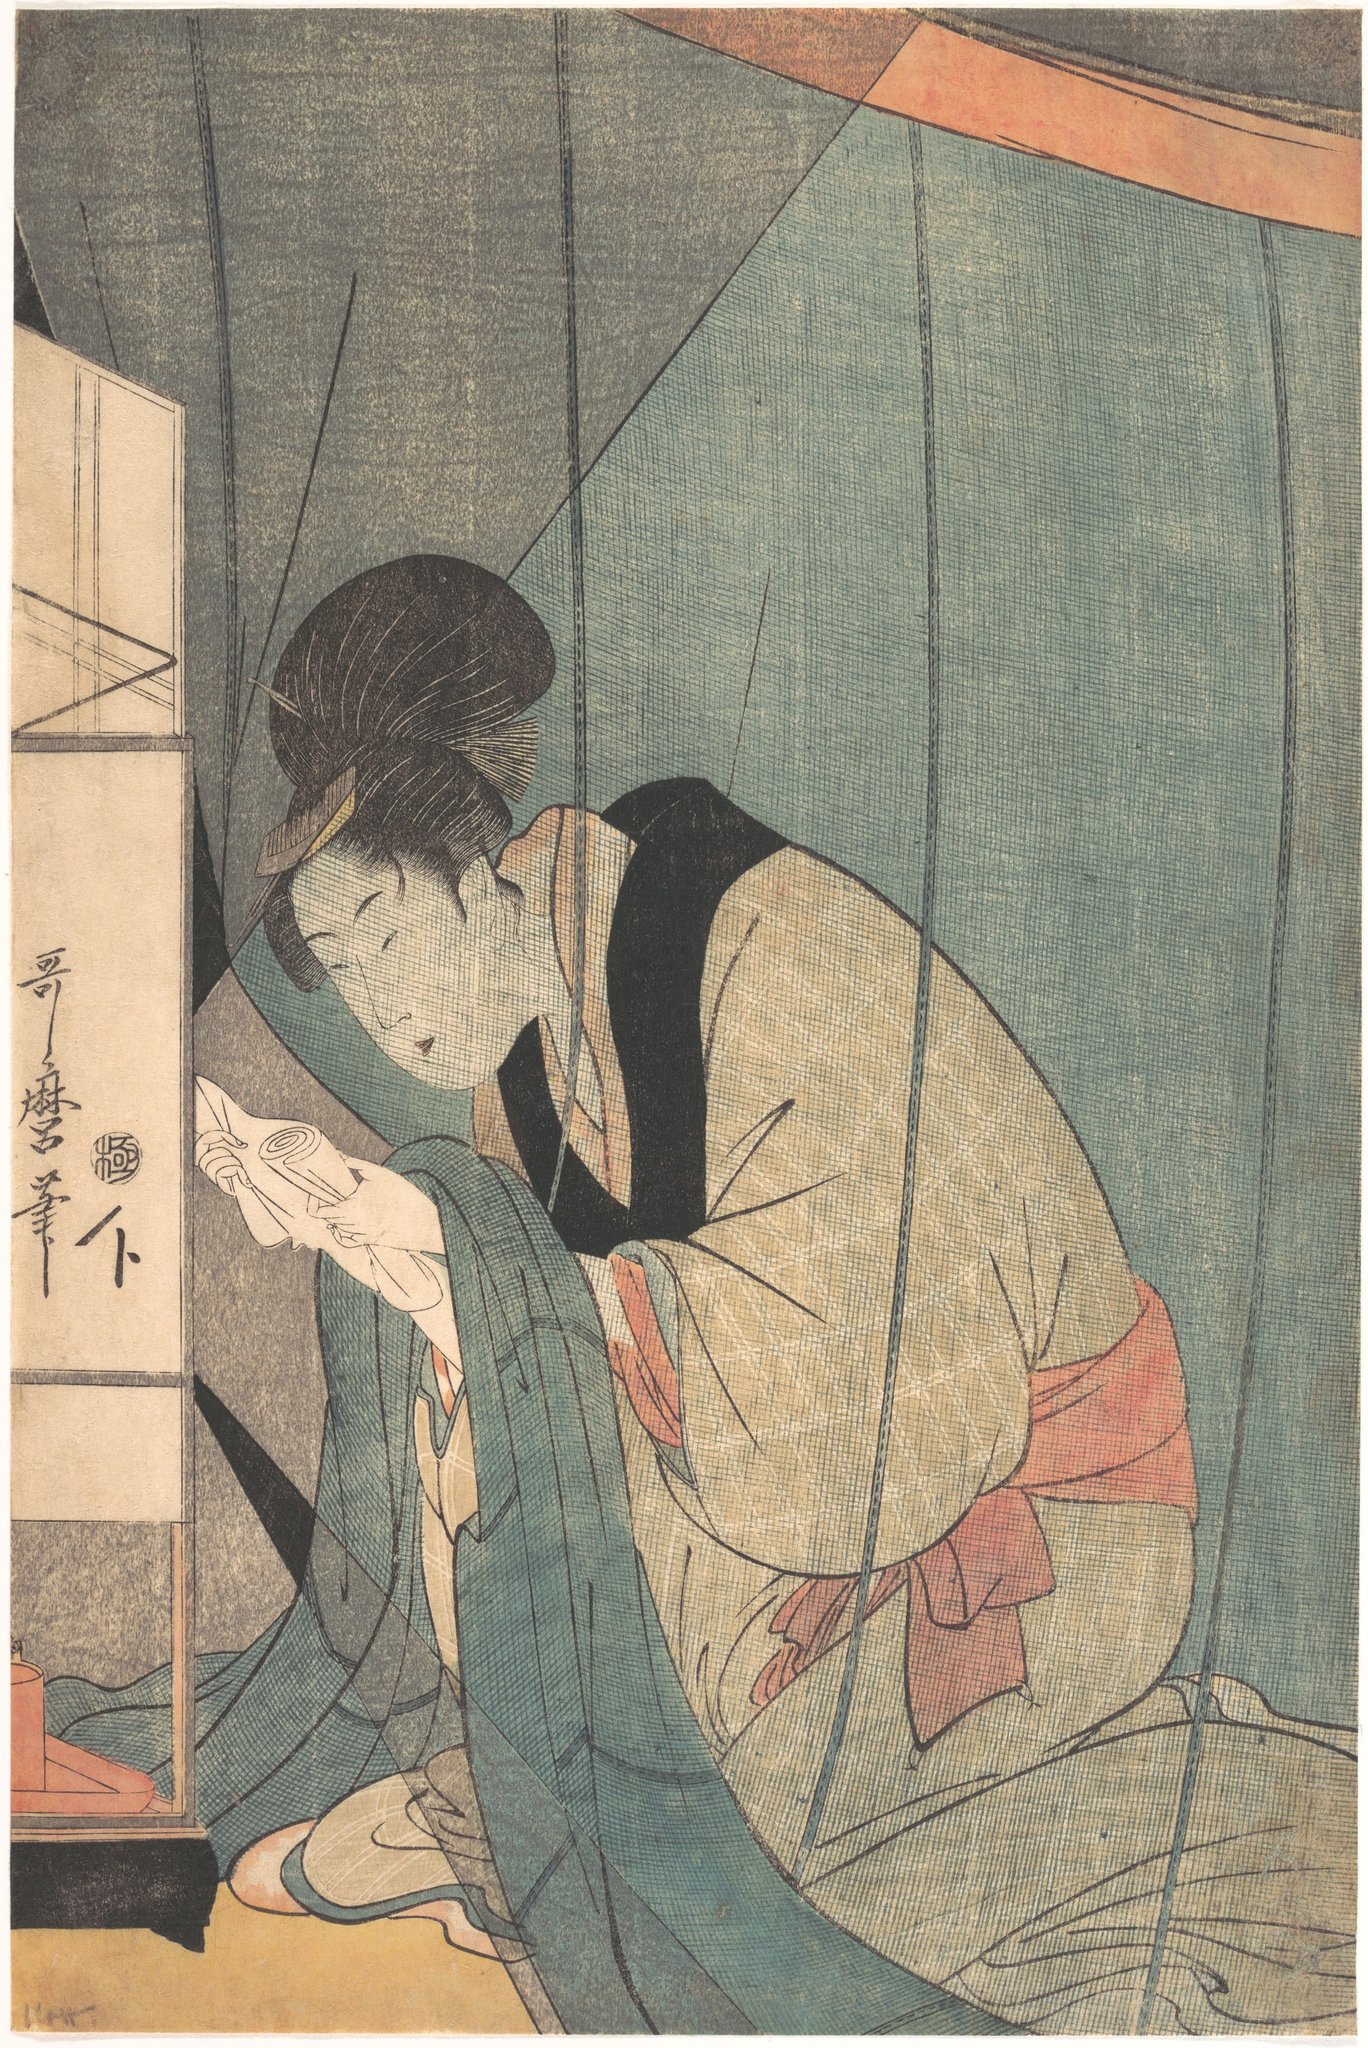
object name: print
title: Woman Reading a Letter under a Mosquito Net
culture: japanese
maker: kitagawa utamaro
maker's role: artist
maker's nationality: japanese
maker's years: 1754-1806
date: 1798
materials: ink, paper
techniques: woodblock print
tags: women,reading